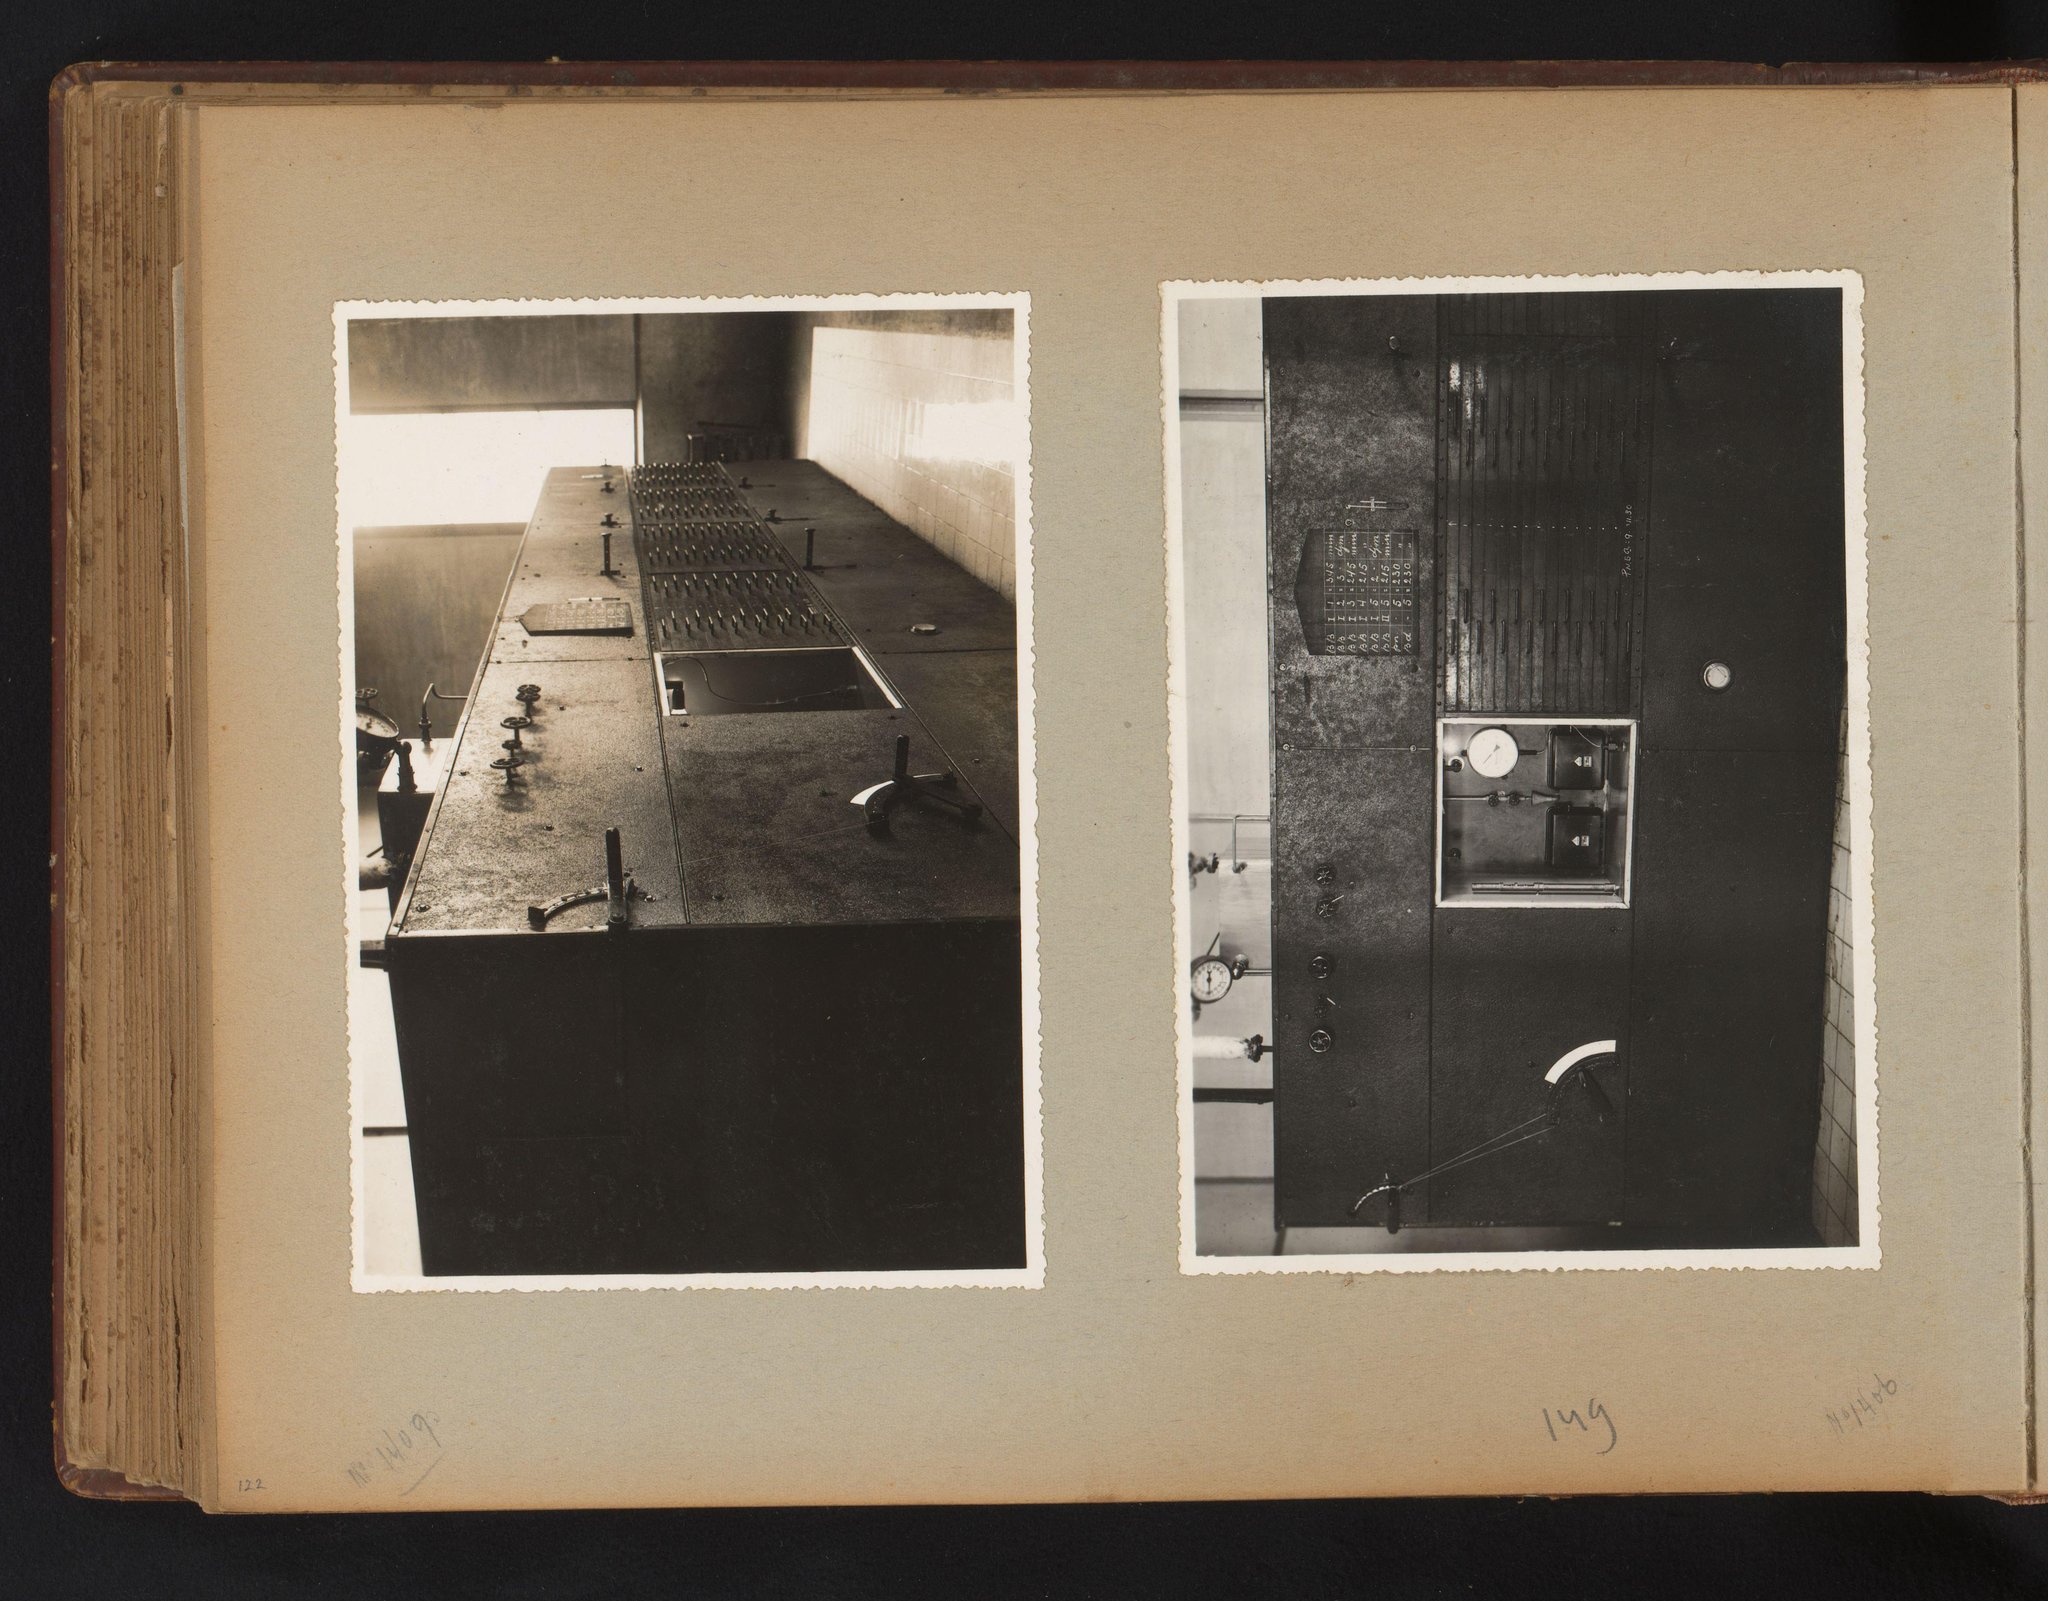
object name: photograph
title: Installatie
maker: Anonymous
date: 1931-1937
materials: cardboard, photographic support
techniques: gelatin silver print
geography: java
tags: machines; parts of machines; tools and appliances, java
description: Albumblad met twee foto's van een installatie. Onderdeel van een fotoalbum met foto's van machines en constructies van de N.V. Machinefabriek Braat te Soerabaja, Soekaboemi en Tegal uit de periode 1931-1937.